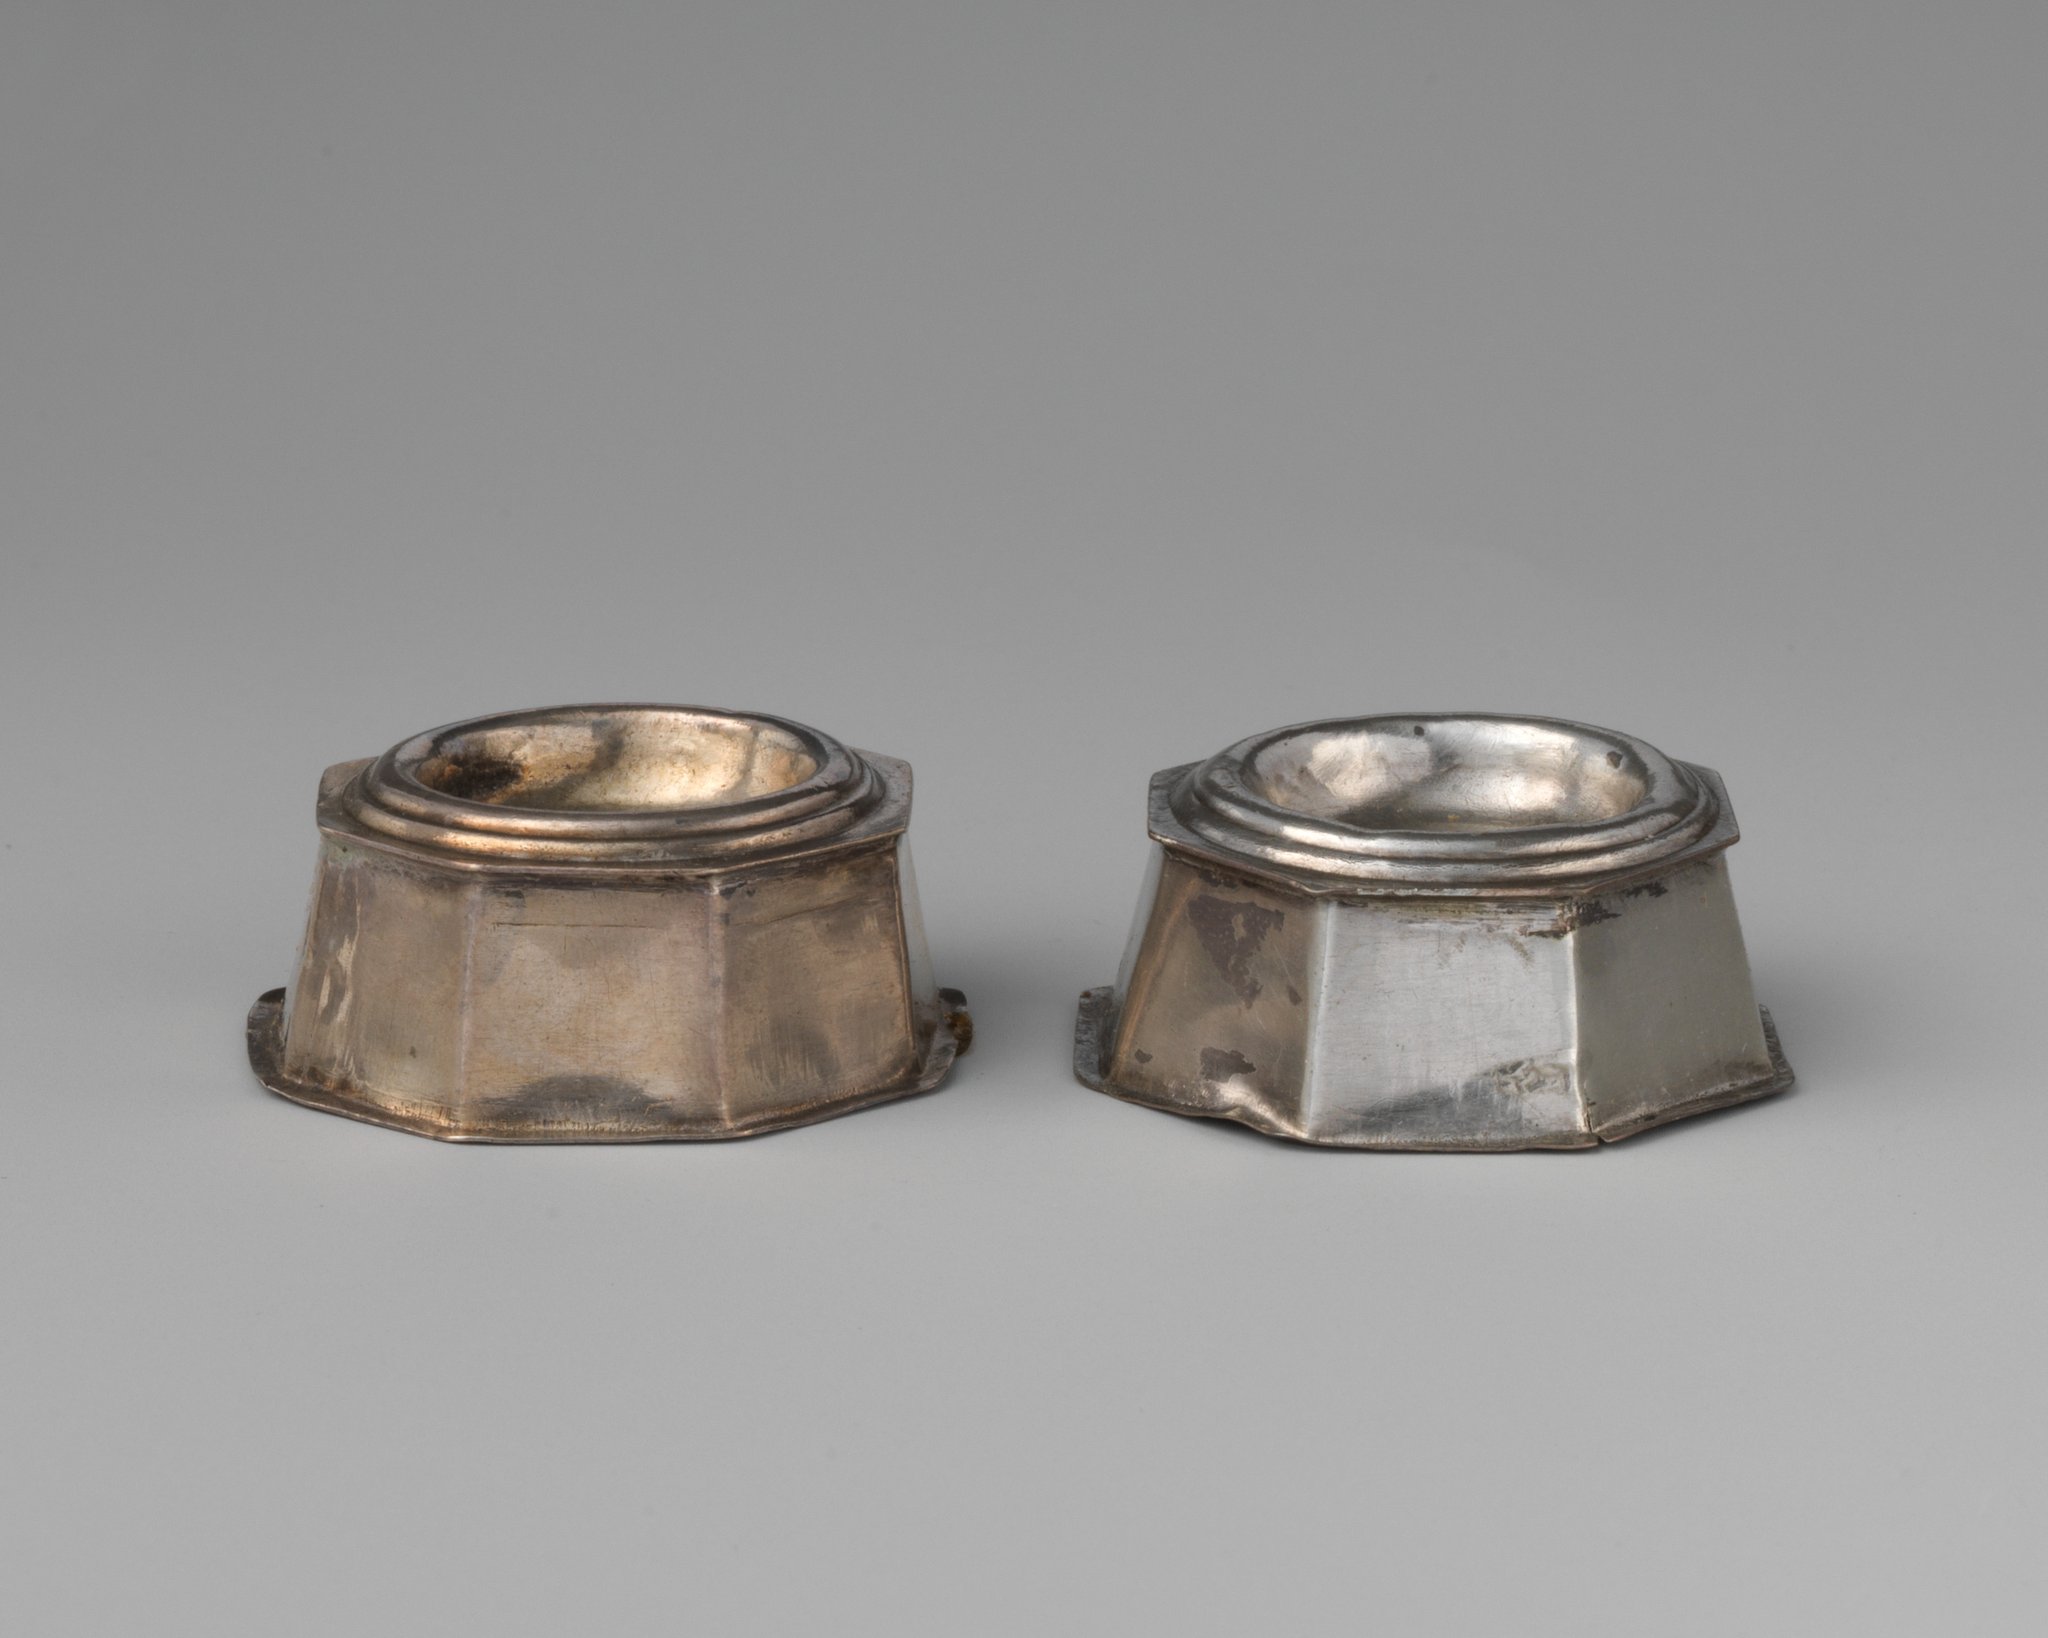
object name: saltcellar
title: Pair of miniature saltcellars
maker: r. g.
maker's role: maker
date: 1727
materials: silver